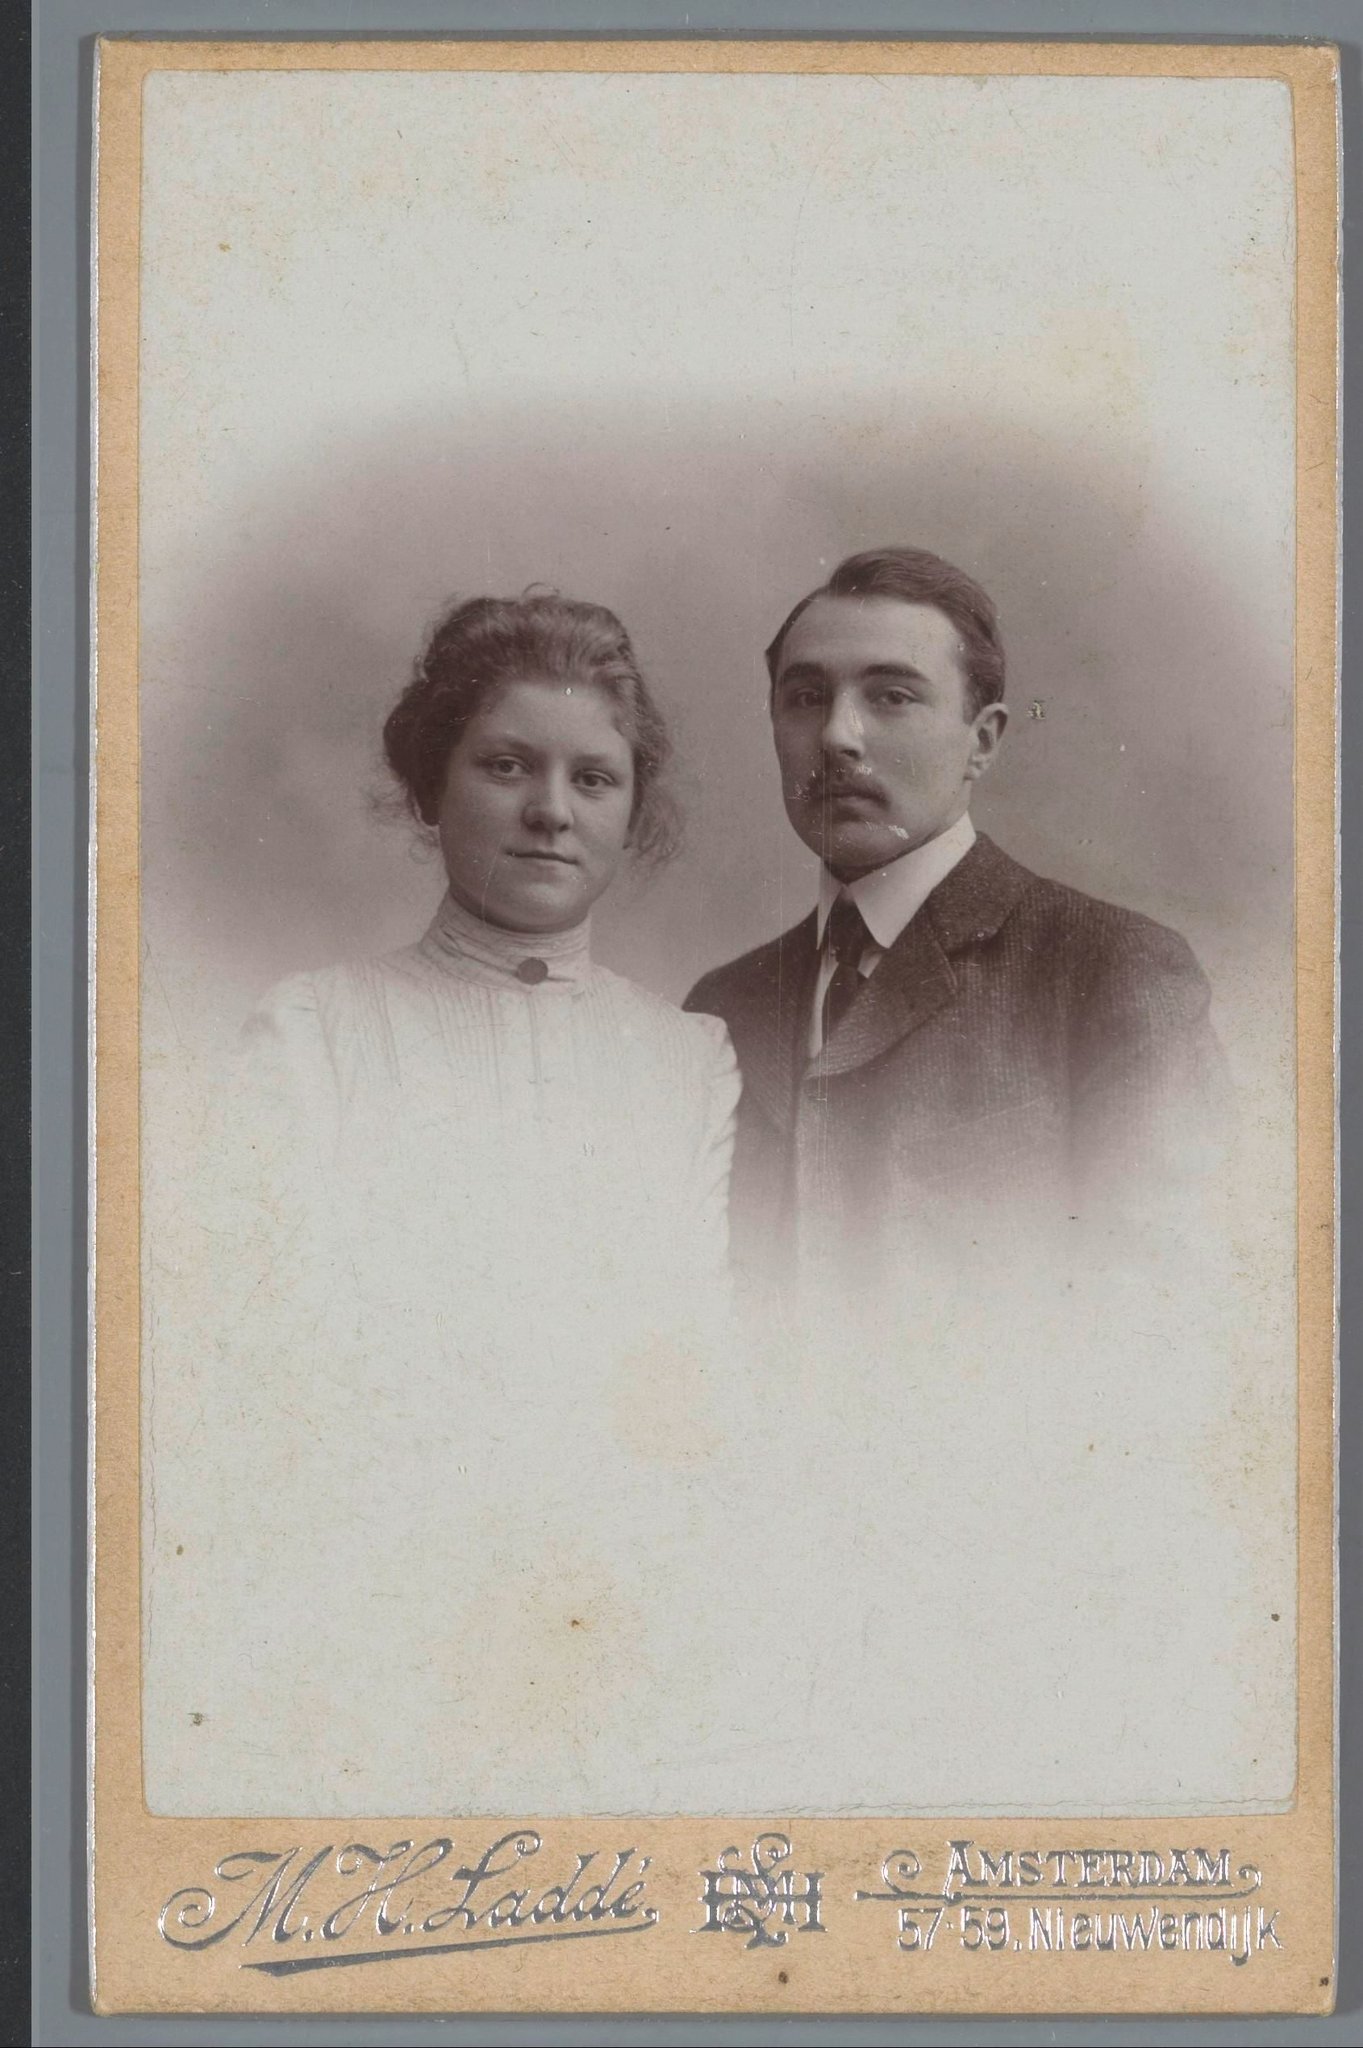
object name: photograph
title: Portret van een onbekende man en vrouw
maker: machiel hendricus laddé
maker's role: fotograaf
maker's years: 1866-1932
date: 1892-1906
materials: paper, cardboard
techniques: collodion silver print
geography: amsterdam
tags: adult woman, adult man, anonymous historical person portrayed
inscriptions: inscription: ‘No ................../ Het Cliche wordt voor verdere bestellingen bewaard.’, address: ‘BOVEN DE FIRMA/ MERKELBACH & CO/ AMSTERDAM/ 57-59/ NIEUWENDIJK’